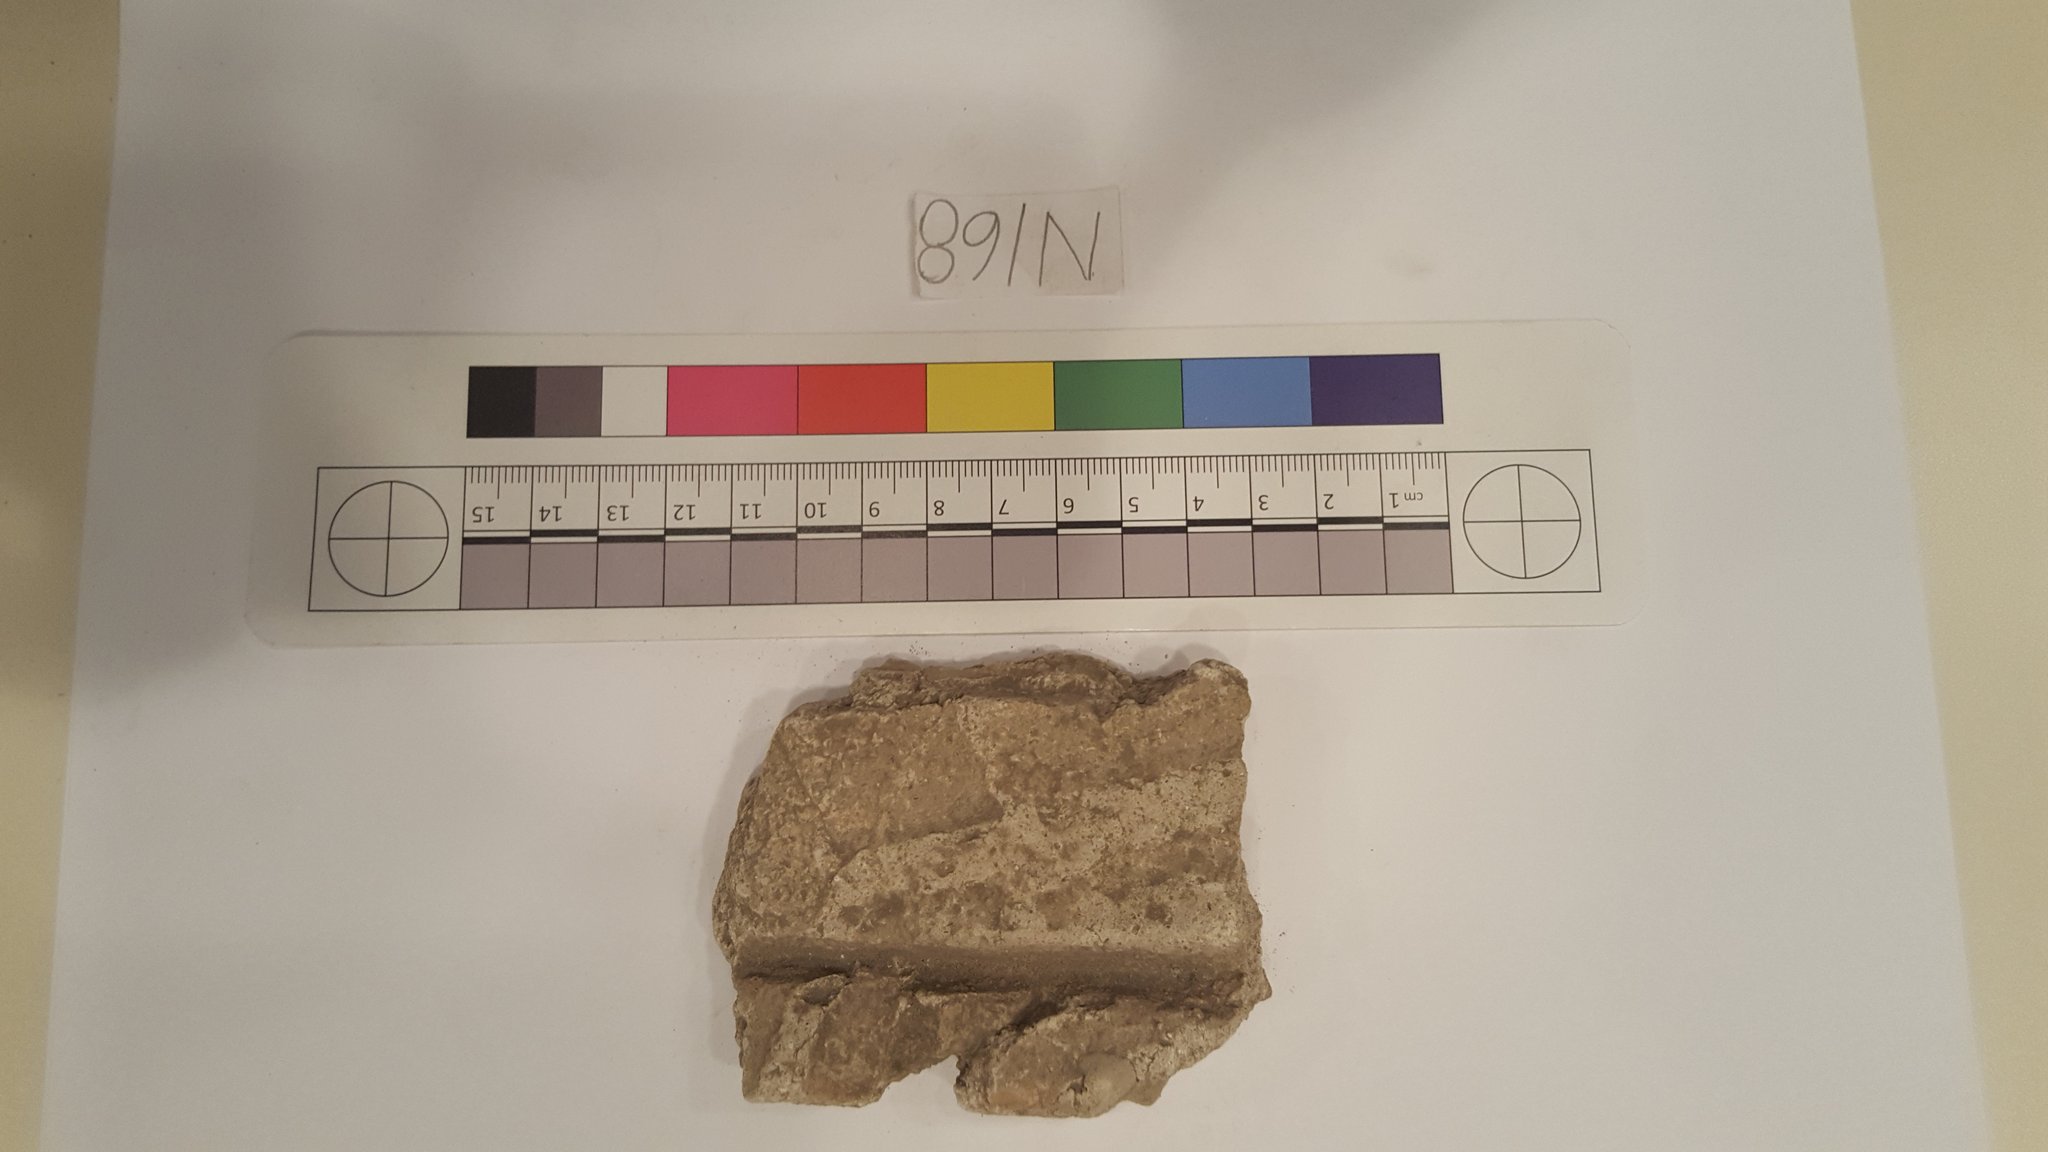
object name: fragment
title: Stucco Fragment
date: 701-1200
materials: plaster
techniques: carving, painting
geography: iran